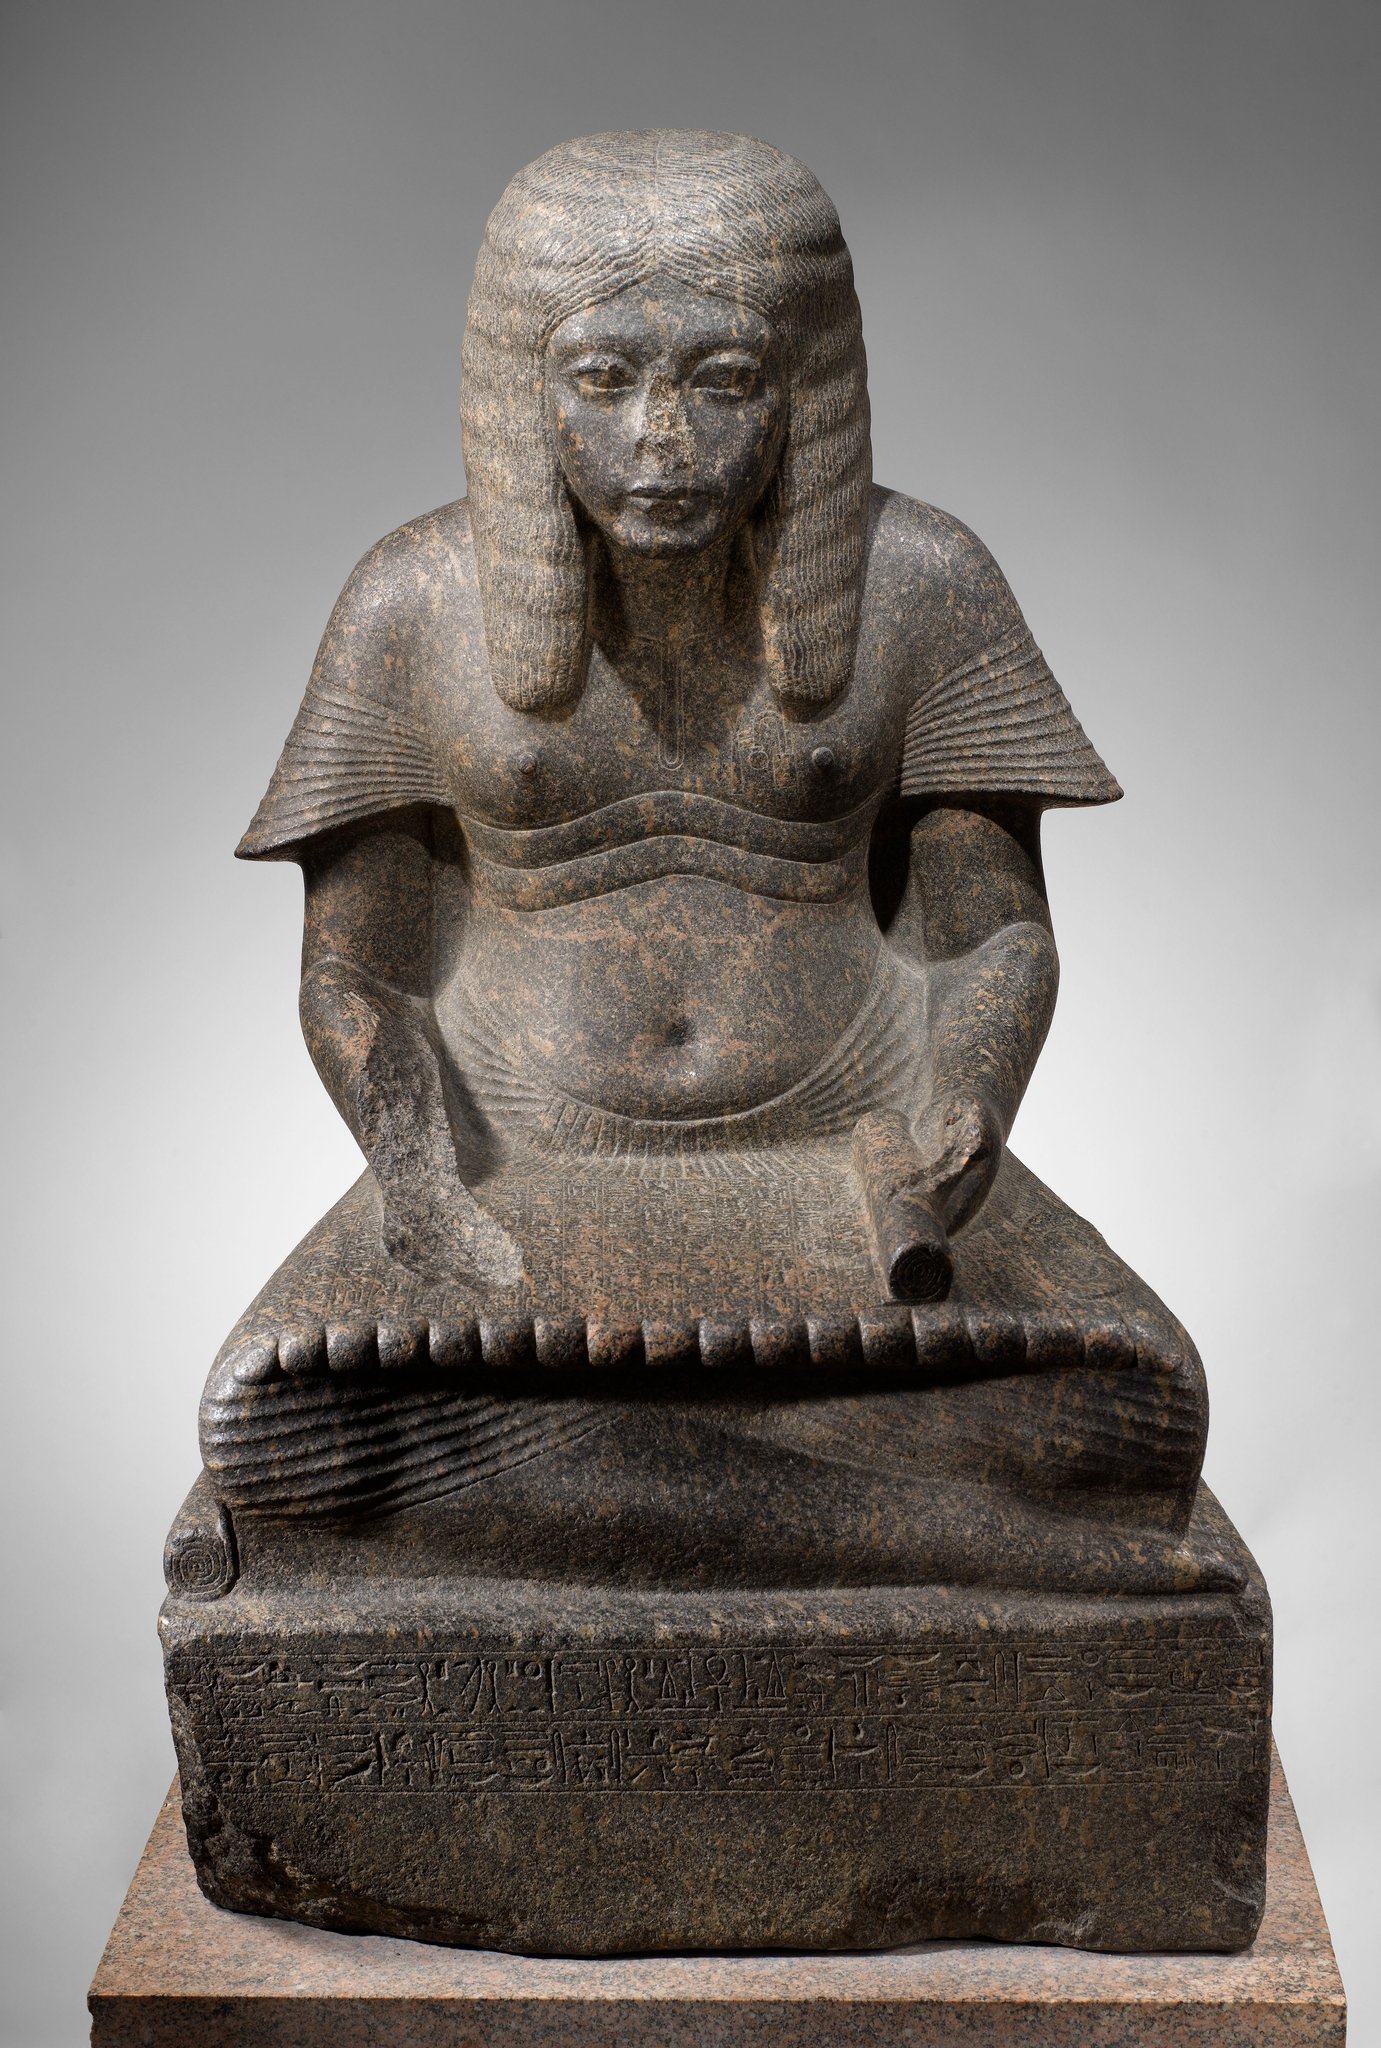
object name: statue, scribe, haremhab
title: Haremhab as a Scribe of the King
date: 1336-1323 BCE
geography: memphite region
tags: men,hieroglyphs